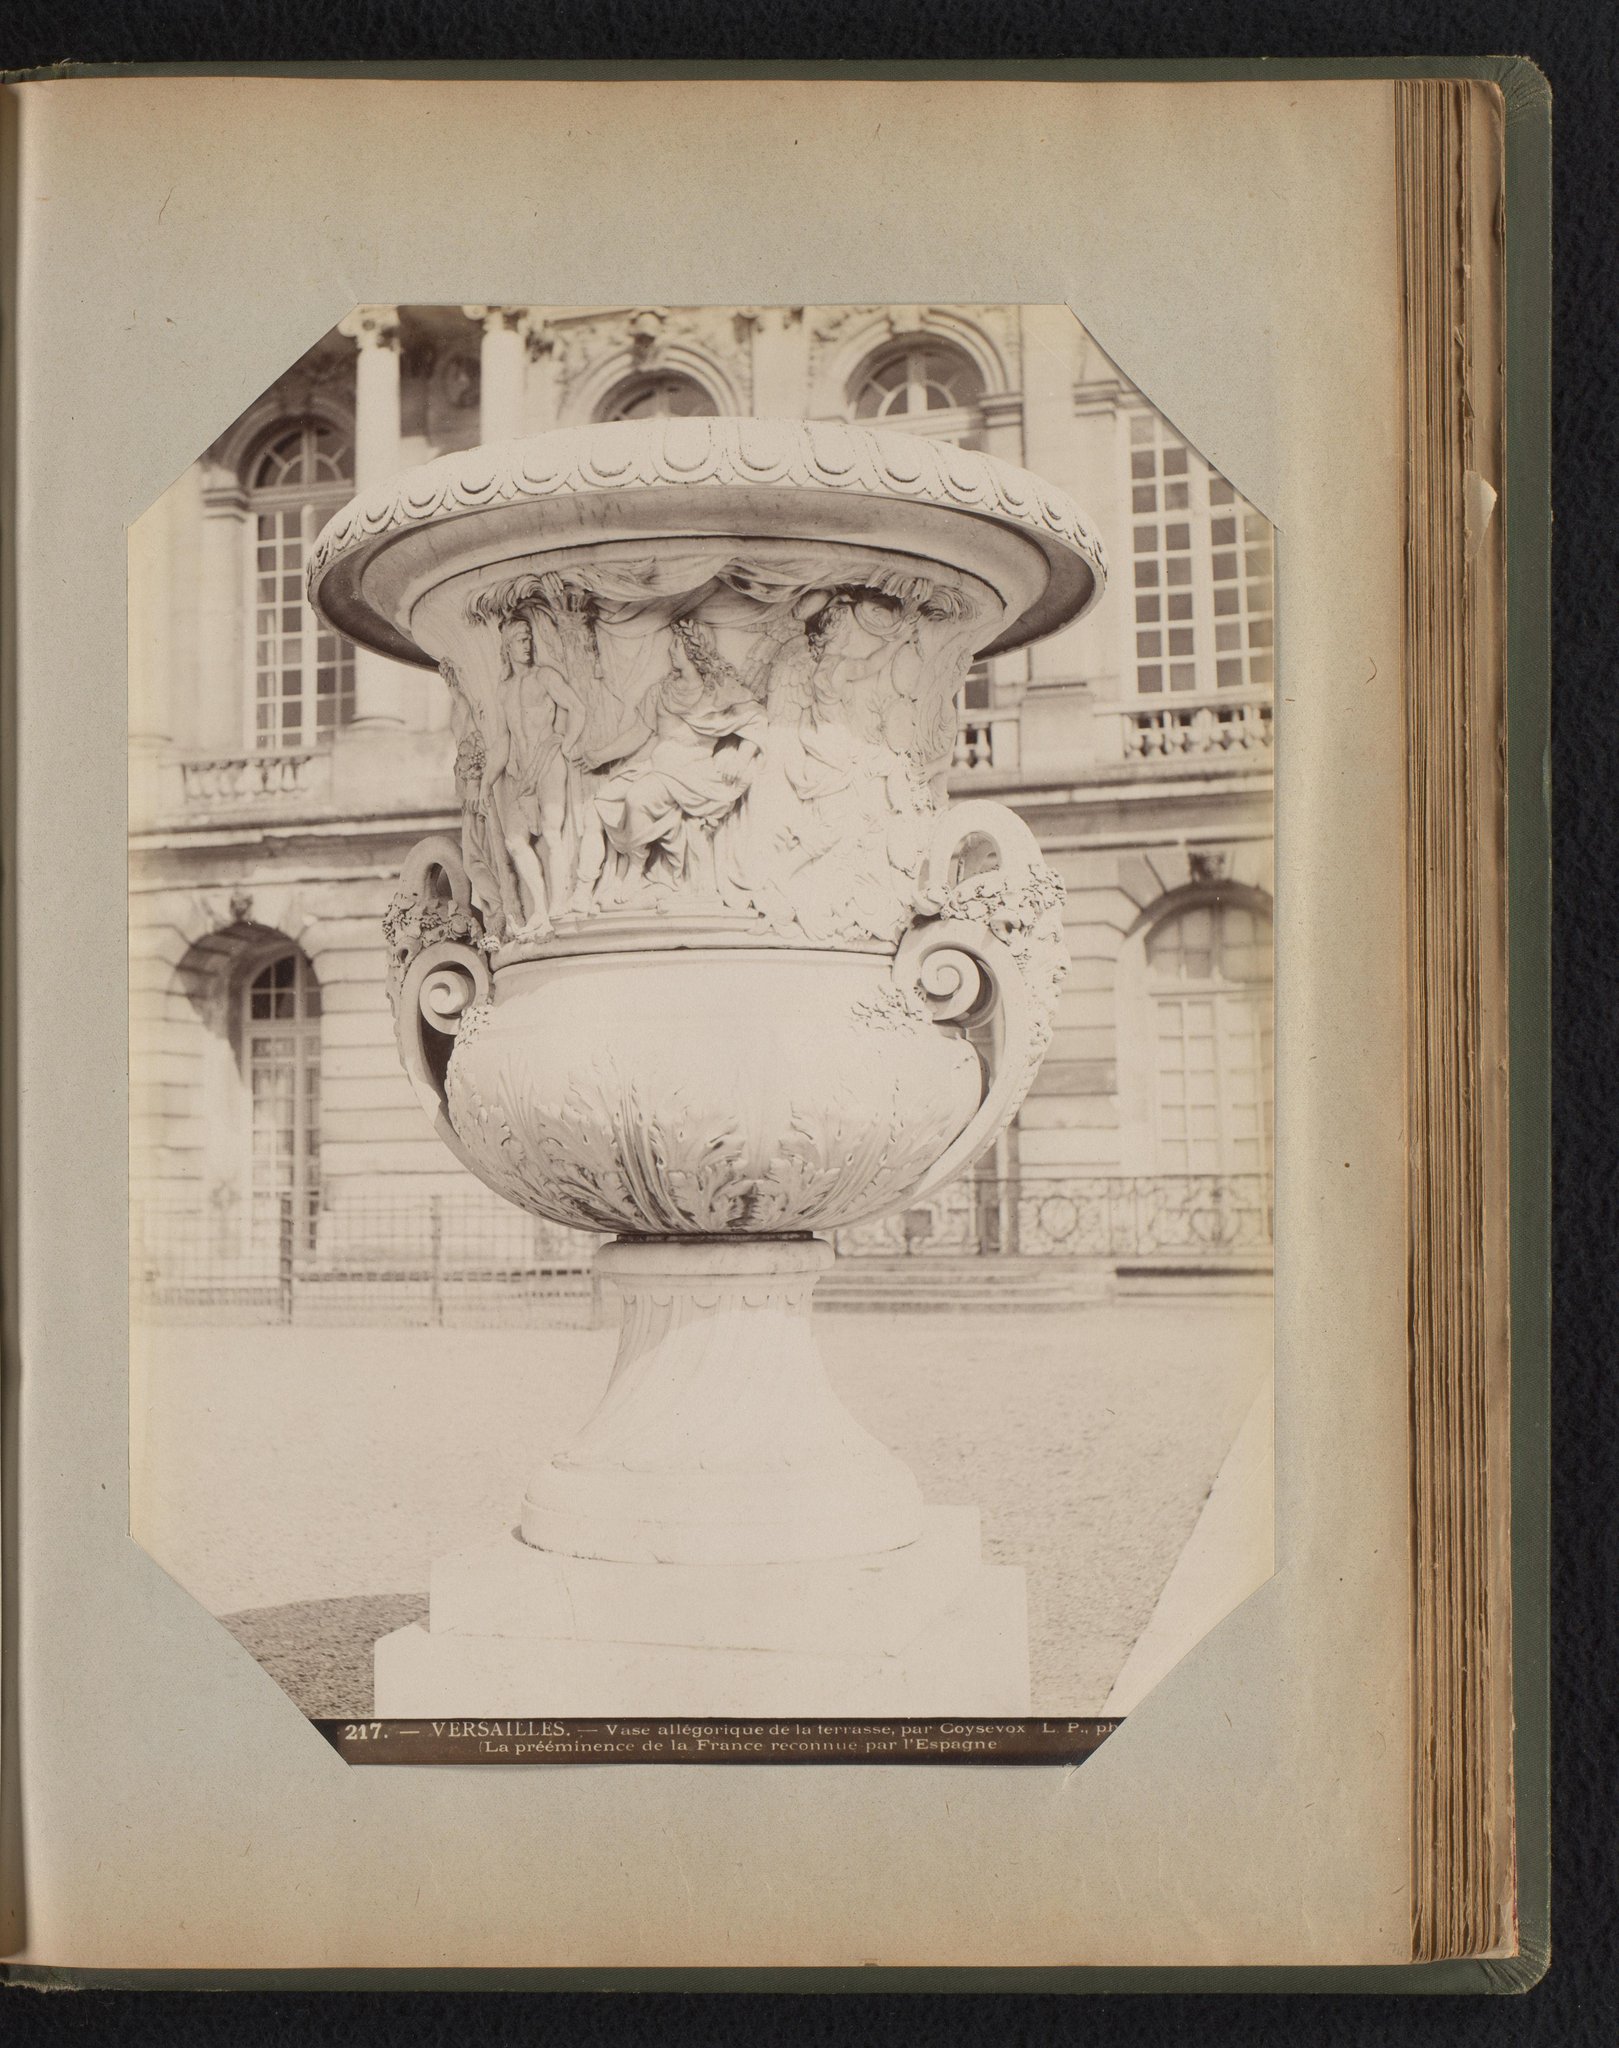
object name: photograph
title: 217 - Versailles - Vase allegorique de la terrasse par Coysevox. (L.P. Phot). (La Preeminence de la France recconnue par l'Espagne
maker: Anonymous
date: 1860-1900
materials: paper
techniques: albumen print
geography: france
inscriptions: annotation: ‘271 - Versailles - Vase allegorique de la terrasse par Coysevox. (L.P. Phot).’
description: Op de vaas staat een voorstelling die de superioriteit van Frankrijk over Spanje beschrijft. Onderdeel van een serie met betrekking tot het interieur van het paleis van Versailles met kroonluchters, deuren, portalen en meubelstukken.